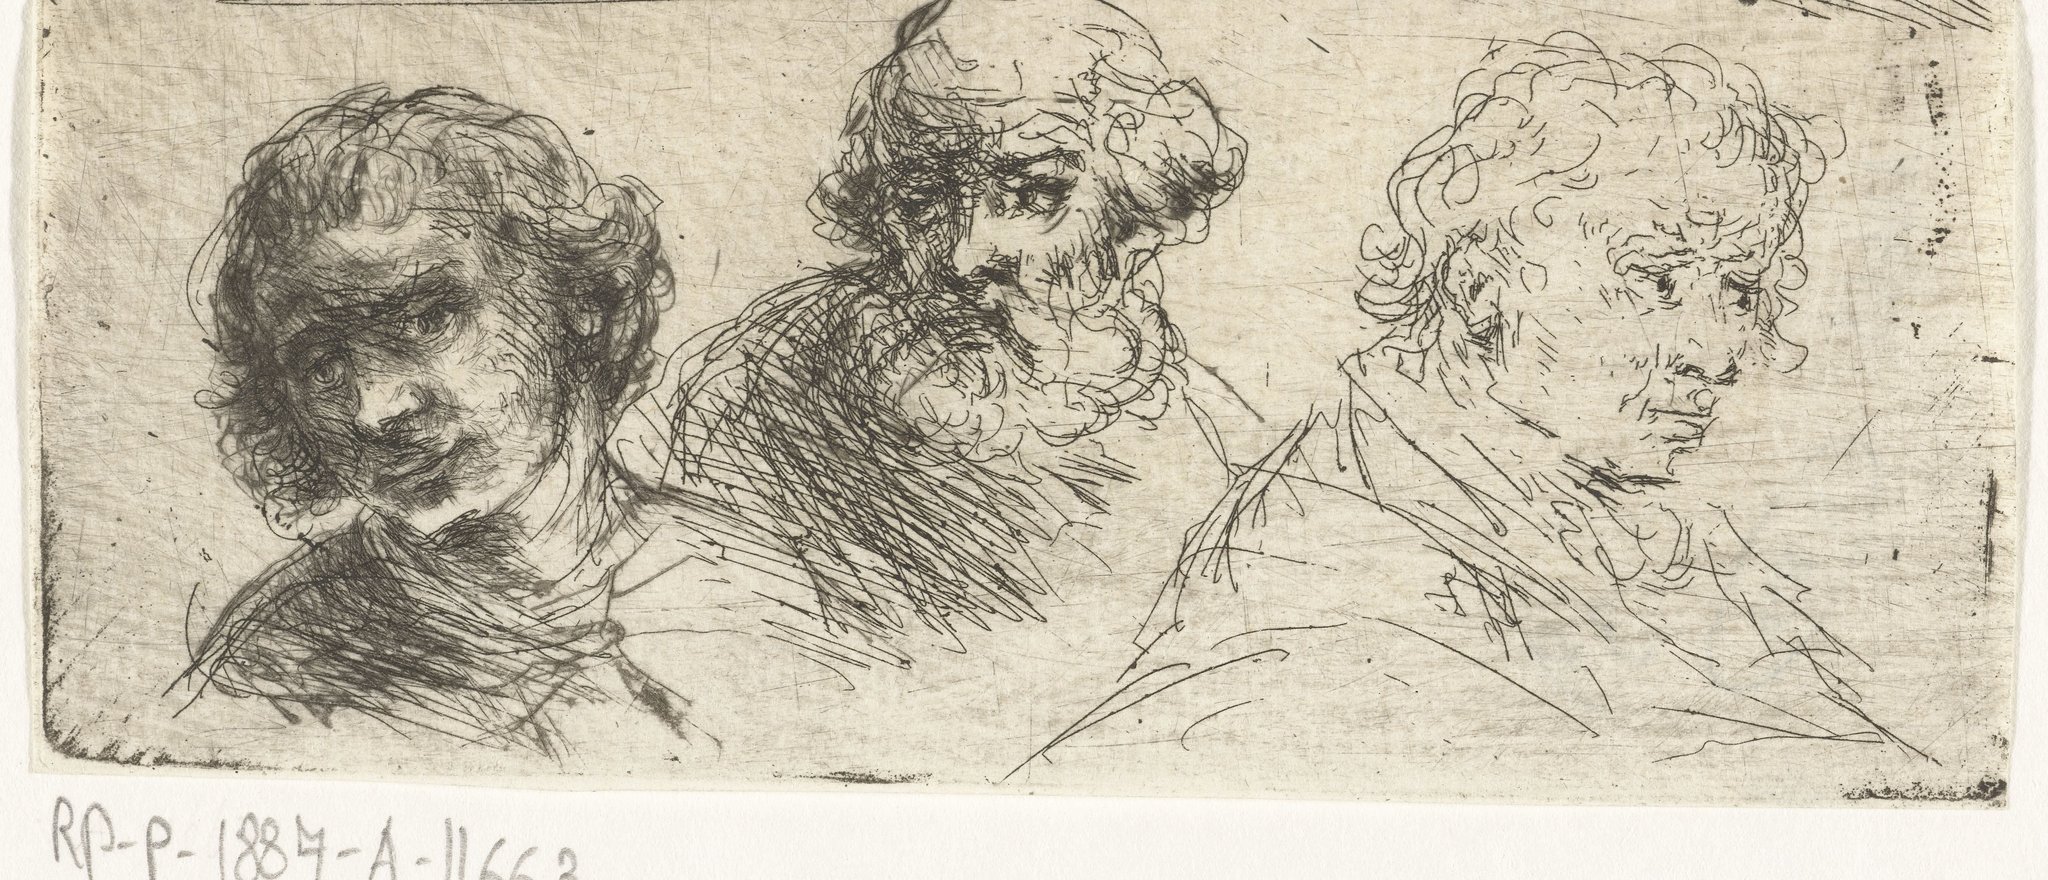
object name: print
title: Portretstudie van drie mannen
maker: jan chalon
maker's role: print maker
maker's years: 1738-1795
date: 1748-1795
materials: paper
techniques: drypoint, etching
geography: northern netherlands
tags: morphology of human expression (+ old male (human being)), morphology of human expression (+ adult male (human being))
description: Portretstudie van drie mannen. De linker is jong met buste naar links. De middenste is oud met buste naar links. De rechter is jong met buste naar rechts.